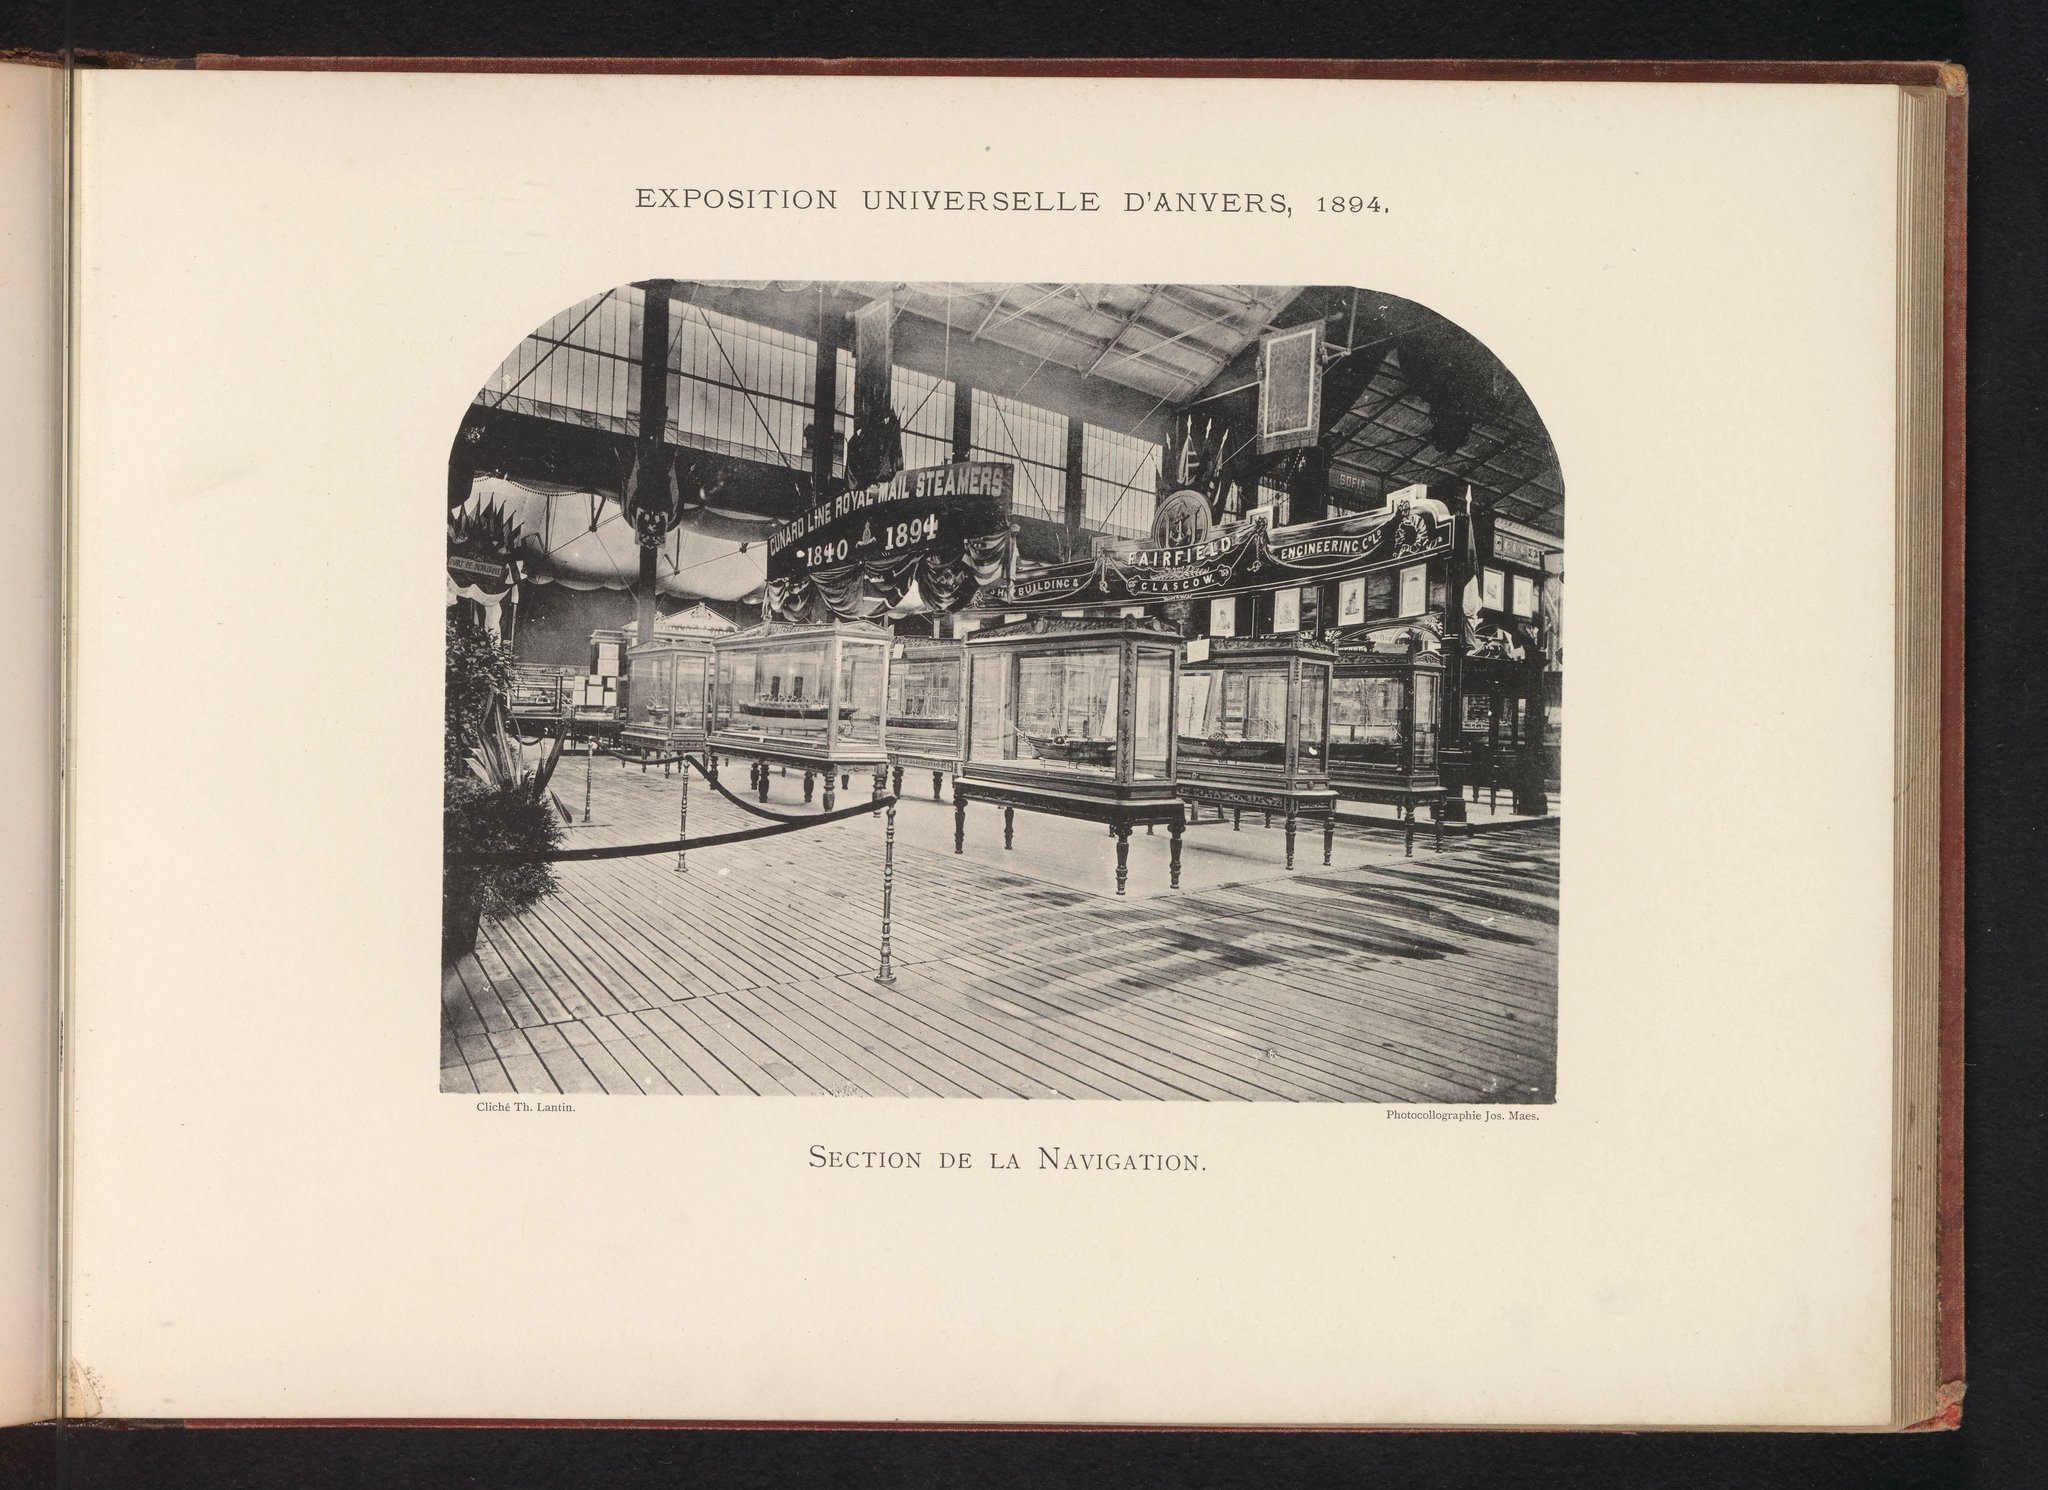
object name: page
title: Expositie van scheepsmodellen tijdens de wereldtentoonstelling te Antwerpen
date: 1894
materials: paper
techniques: photograph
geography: antwerp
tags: world fair, world exhibition, collection, exhibition, show, ship-model